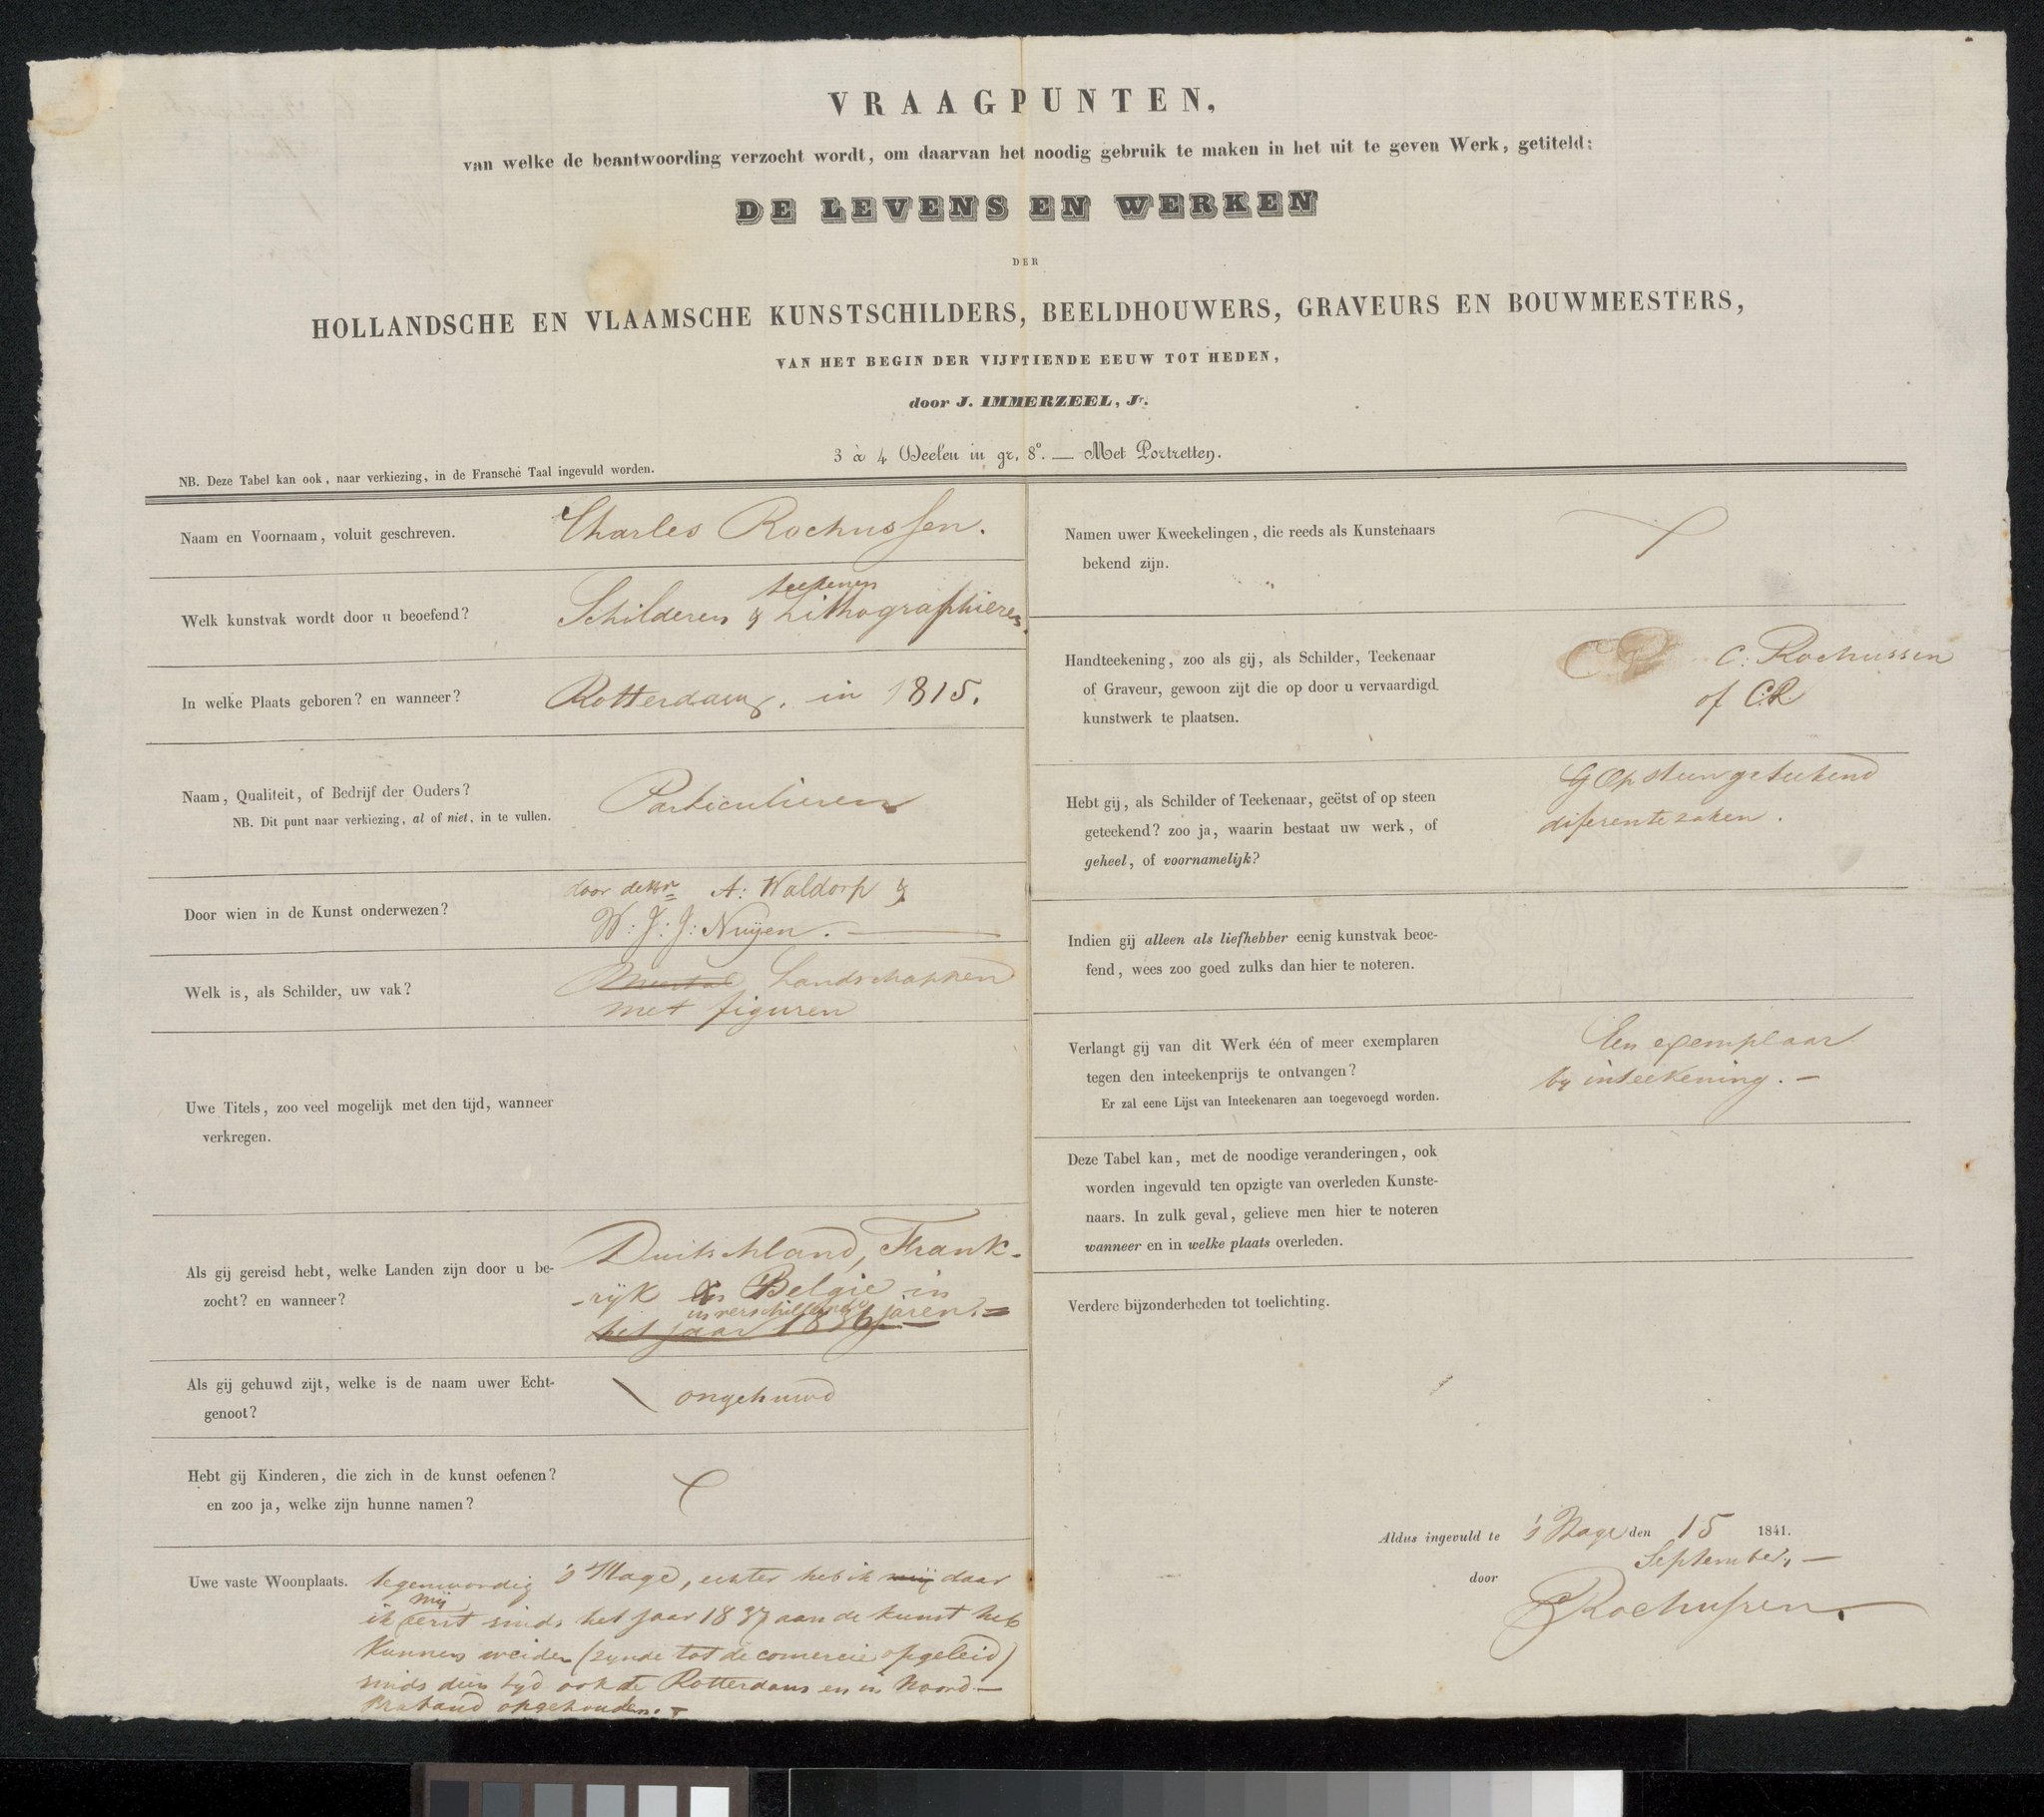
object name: manuscript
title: Enquêteformulier ingevuld door Charles Rochussen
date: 1841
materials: ink, paper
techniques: pen, printing, writing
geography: the hague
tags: rotterdam, painter, draughtsman, charles rochussen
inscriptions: watermark, inscription: ‘Vraagpunten,/ van welke de beantwoording verzocht wordt, om daarvan het noodig gebruik te maken in het uit te geven Werk, getiteld: De levens en werken/ der Hollandsche en Vlaamsche kunstschilders, beeldhouwers,/ graveurs en bouwmeesters, van het begin der vijftiende eeuw tot heden/ door J. Immerzeel, Jr.’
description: Opgenomen in: Immerzeel, J. Jr., De levens en werken der Hollandsche en Vlaamsche kunstschilders, beeldhouwers, graveurs en bouwmeesters, van het begin der vijftiende eeuw tot heden, Amsterdam: J.C. van Kesteren, 1842-1843.